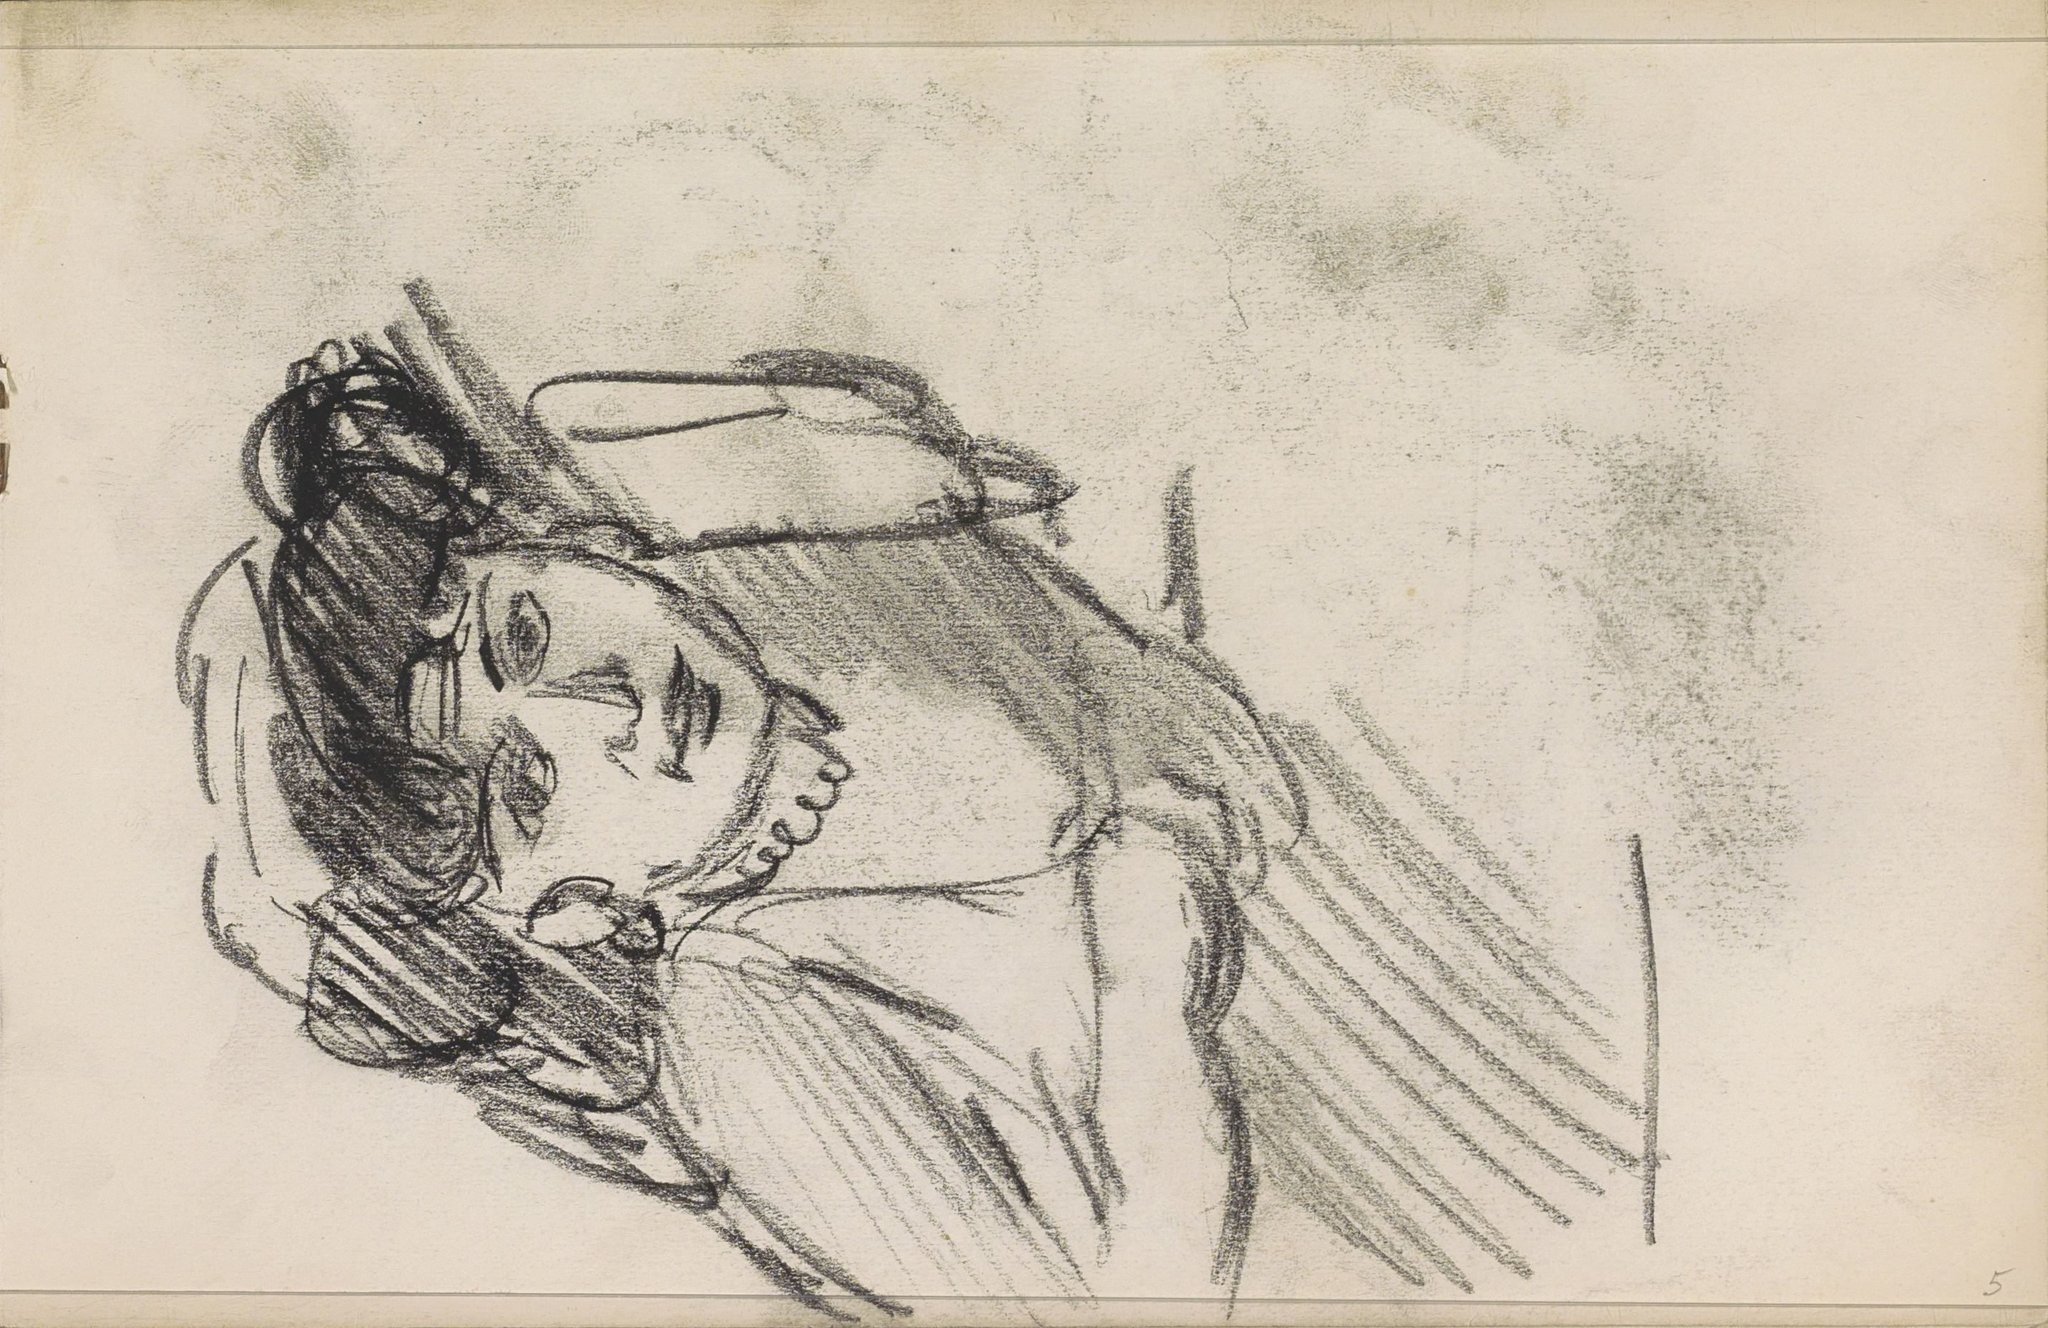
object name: sketchbook leaf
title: Naar voren leunende vrouw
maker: isaac israels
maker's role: draughtsman, painter, print maker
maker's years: 1865-1934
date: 1875-1934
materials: chalk, paper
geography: paris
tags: leaning forward - aa - female human figure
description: Ze steunt op haar arm. Blad 5 recto uit schetsboek LI met 11 bladen.